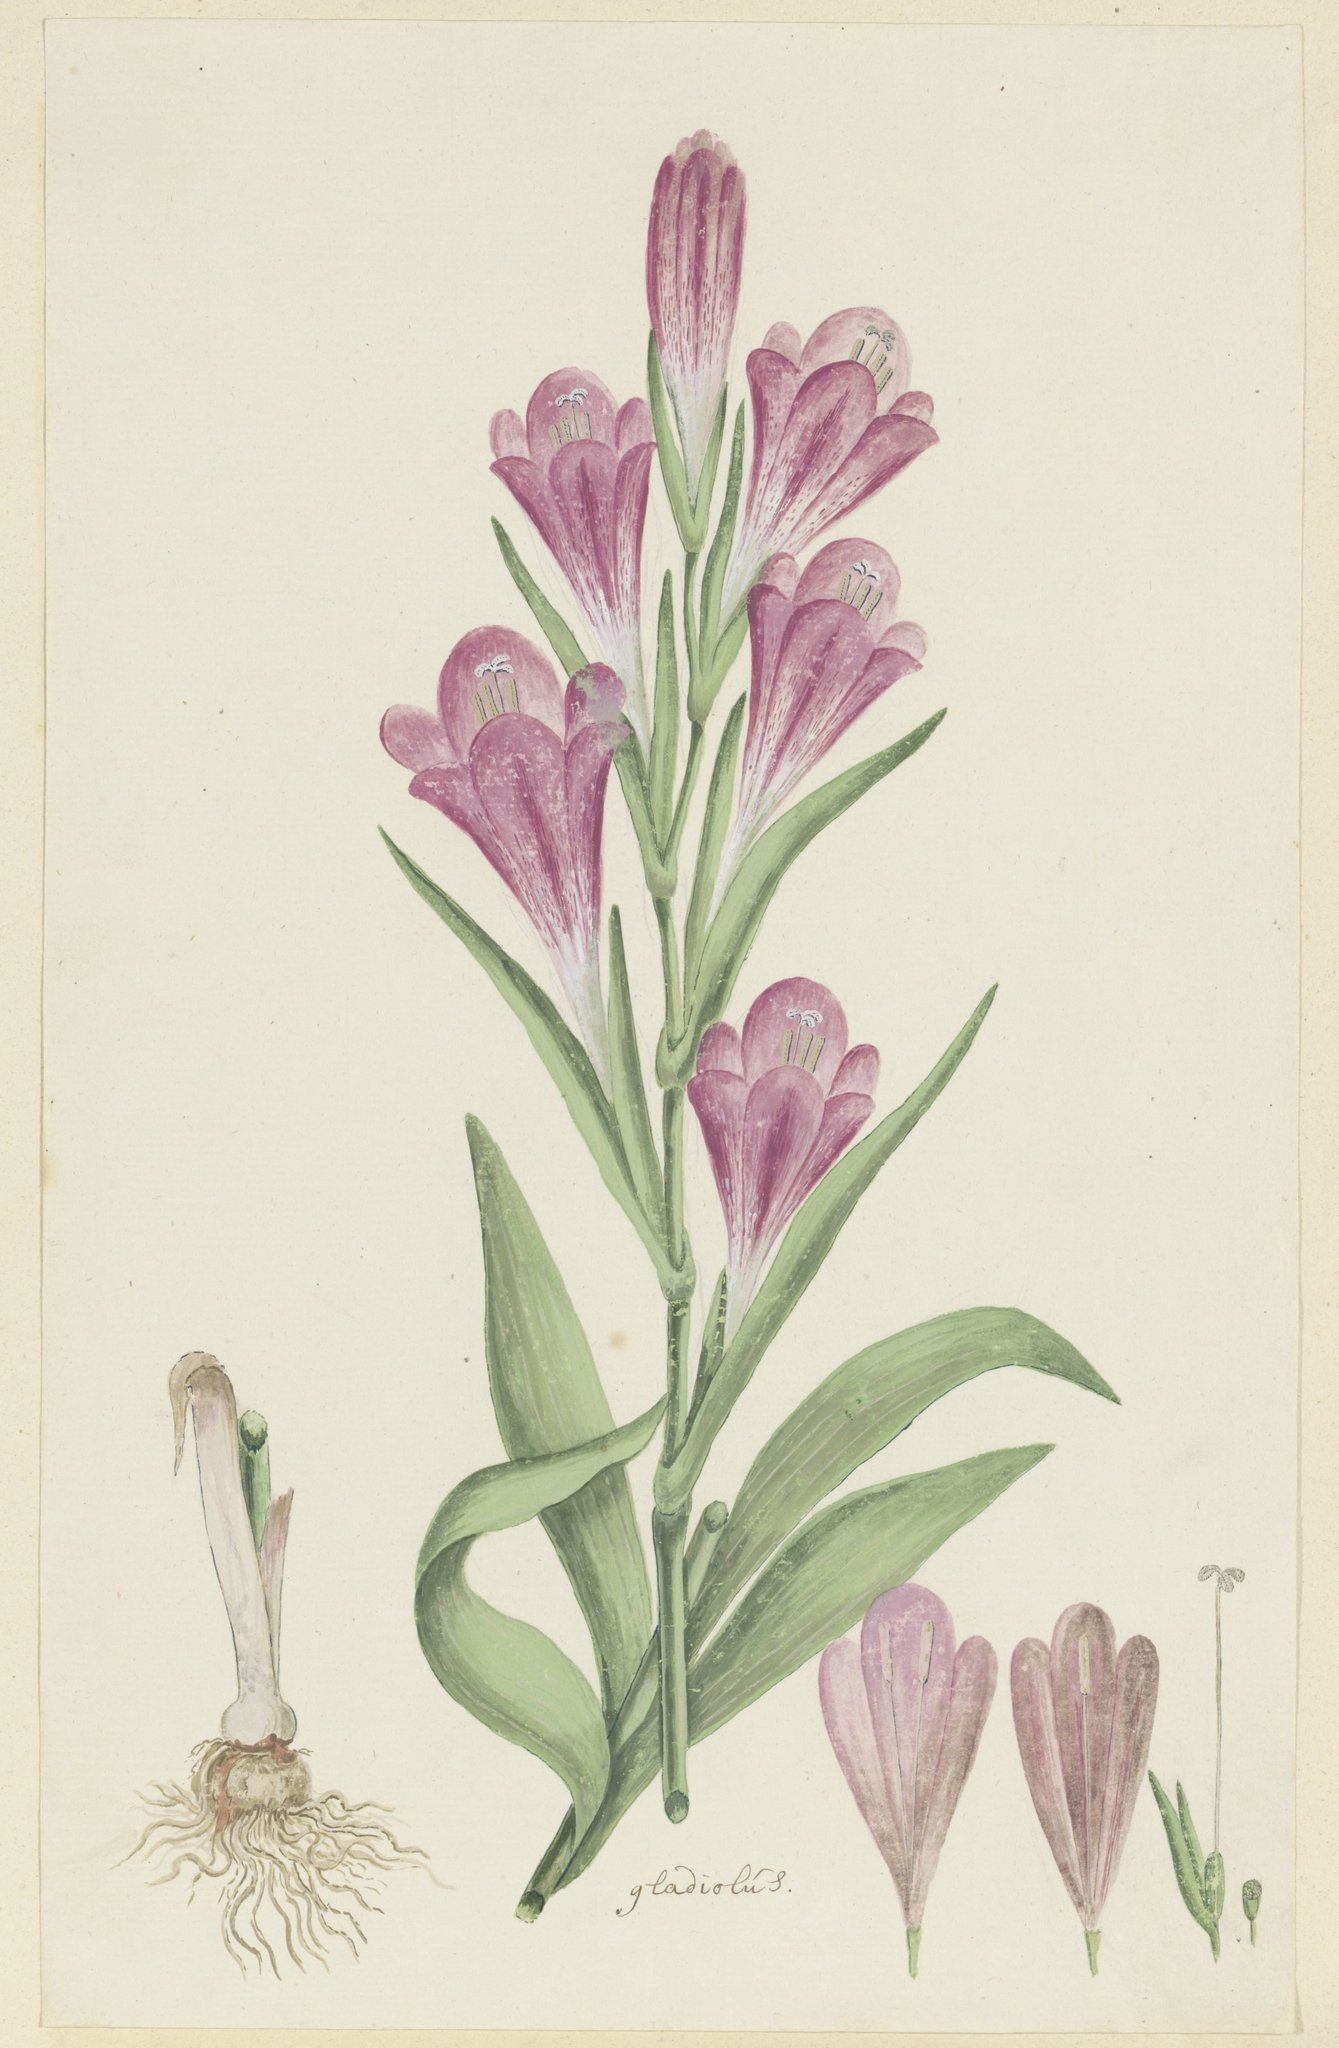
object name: album leaf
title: Gladiolus caryphyllaceus (Burm,f.) Poir.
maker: robert jacob gordon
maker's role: draughtsman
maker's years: 1743-1795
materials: chalk, paint, ink, paper, pencil, watercolor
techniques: brush, pen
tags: plants; vegetation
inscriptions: annotation: ‘gladiolus’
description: De tekening is gemaakt voor of tijdens een van Gordon's vier expedities door de Kaapprovincie, van oktober 1777 tot maart 1786. Sommige (soort)namen kunnen zijn gewijzigd, gezien reorganisatie in plantentaxonomie gedurende de afgelopen jaren.